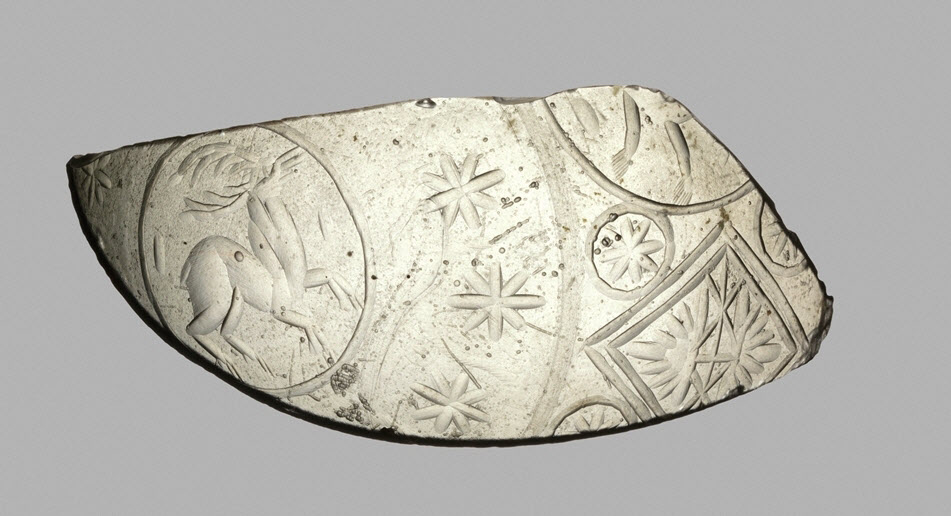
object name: fragment of a bowl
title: Glass bowl fragment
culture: roman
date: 201-400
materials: glass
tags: deer